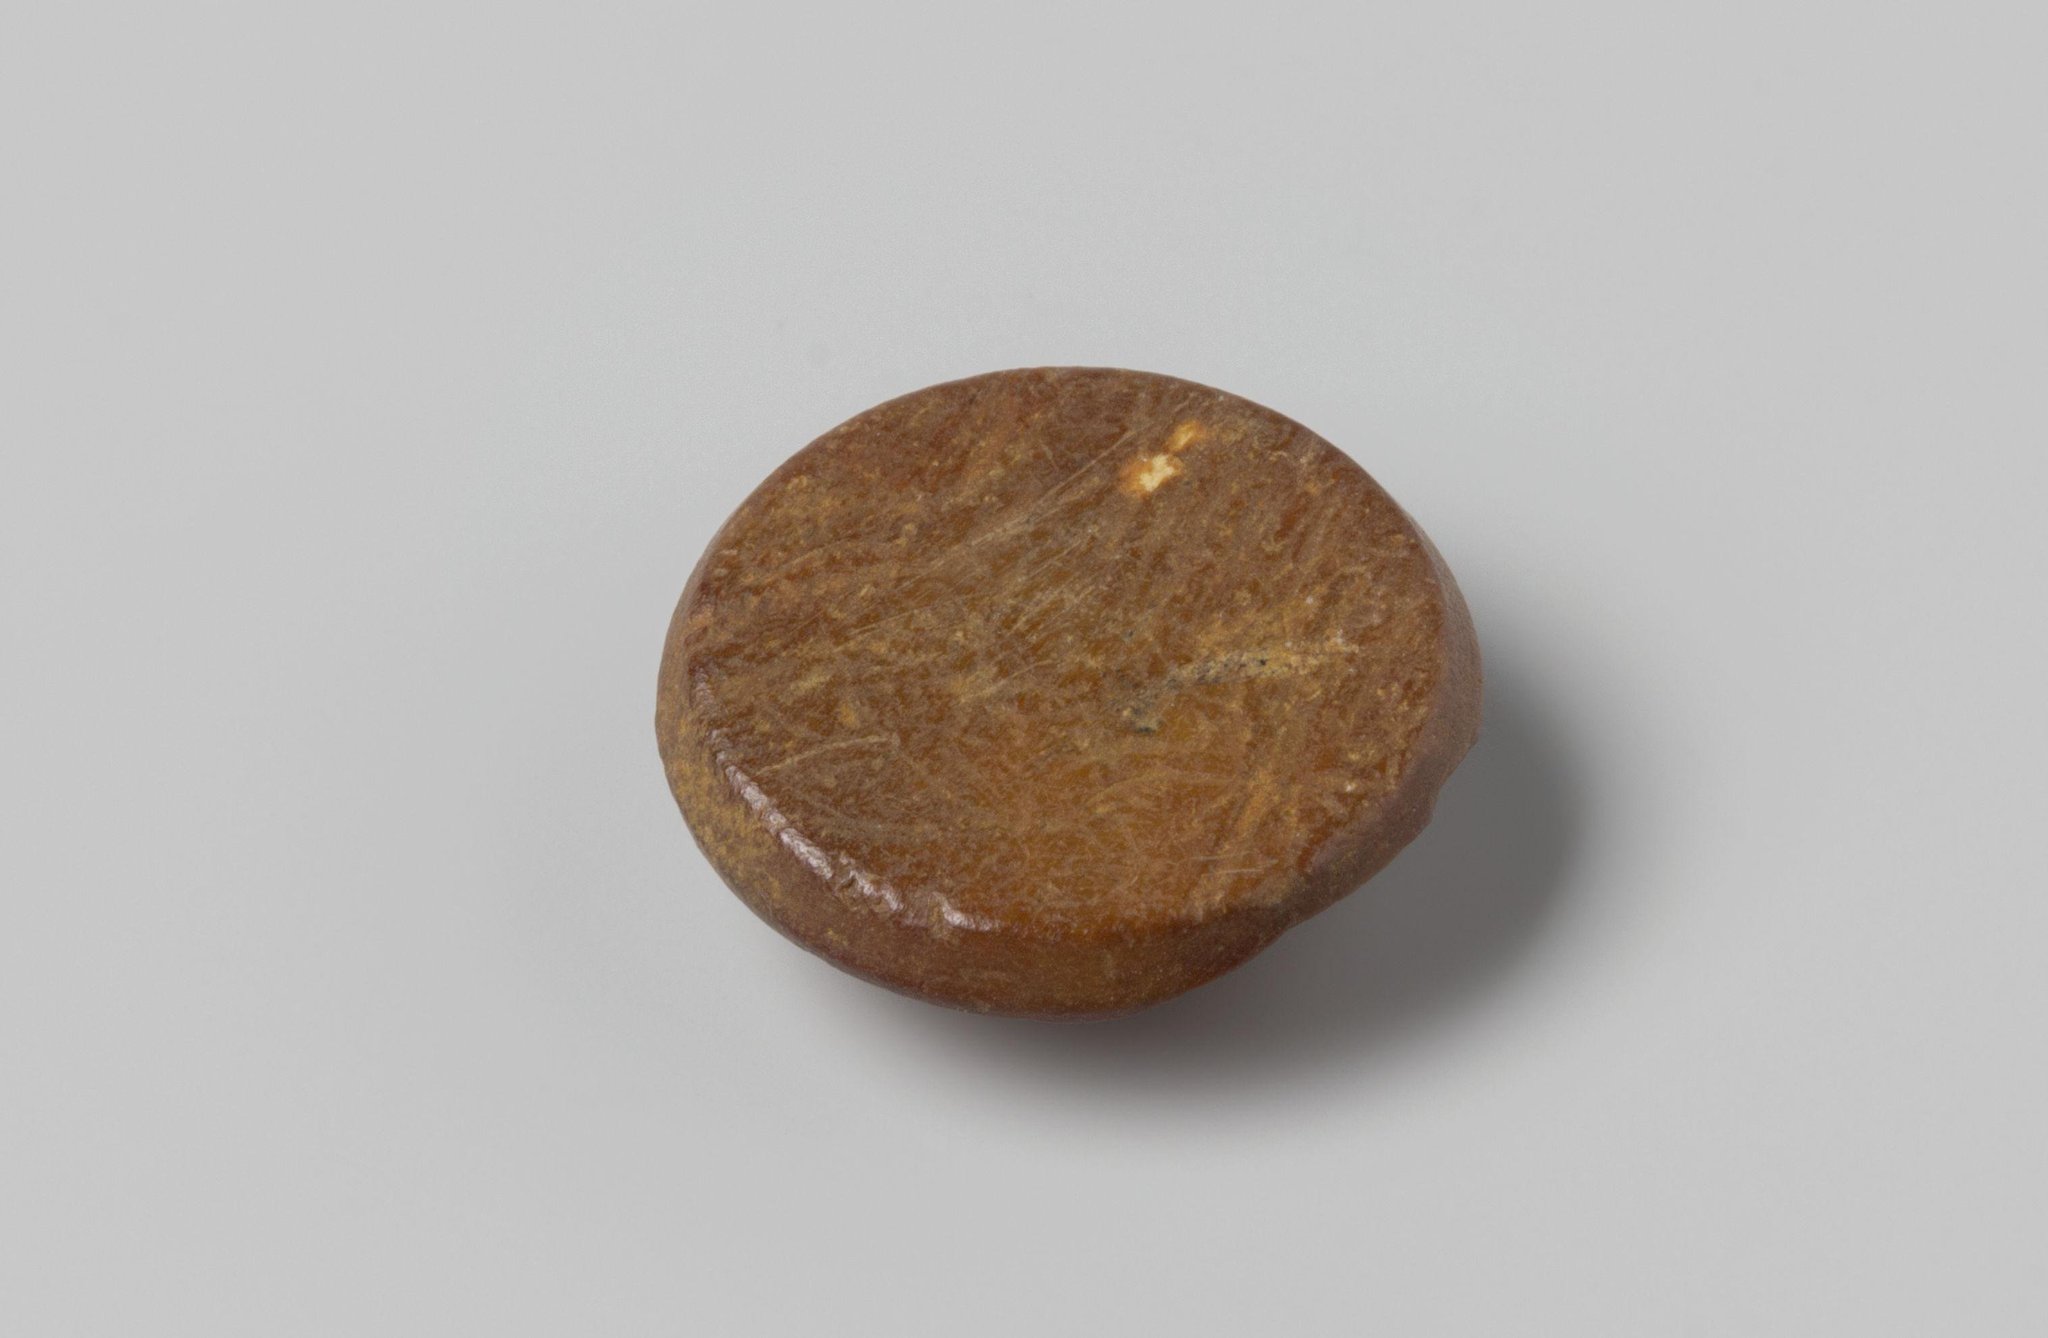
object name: button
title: Knoop uit het wrak van de Oost-Indiëvaarder Hollandia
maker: Anonymous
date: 1700-1743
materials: bone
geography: netherlands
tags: verenigde oostindische compagnie, hollandia (schip), annet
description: Knoop. (1) sim. NG 1980-27H1502 (1.8d, 0.3t)